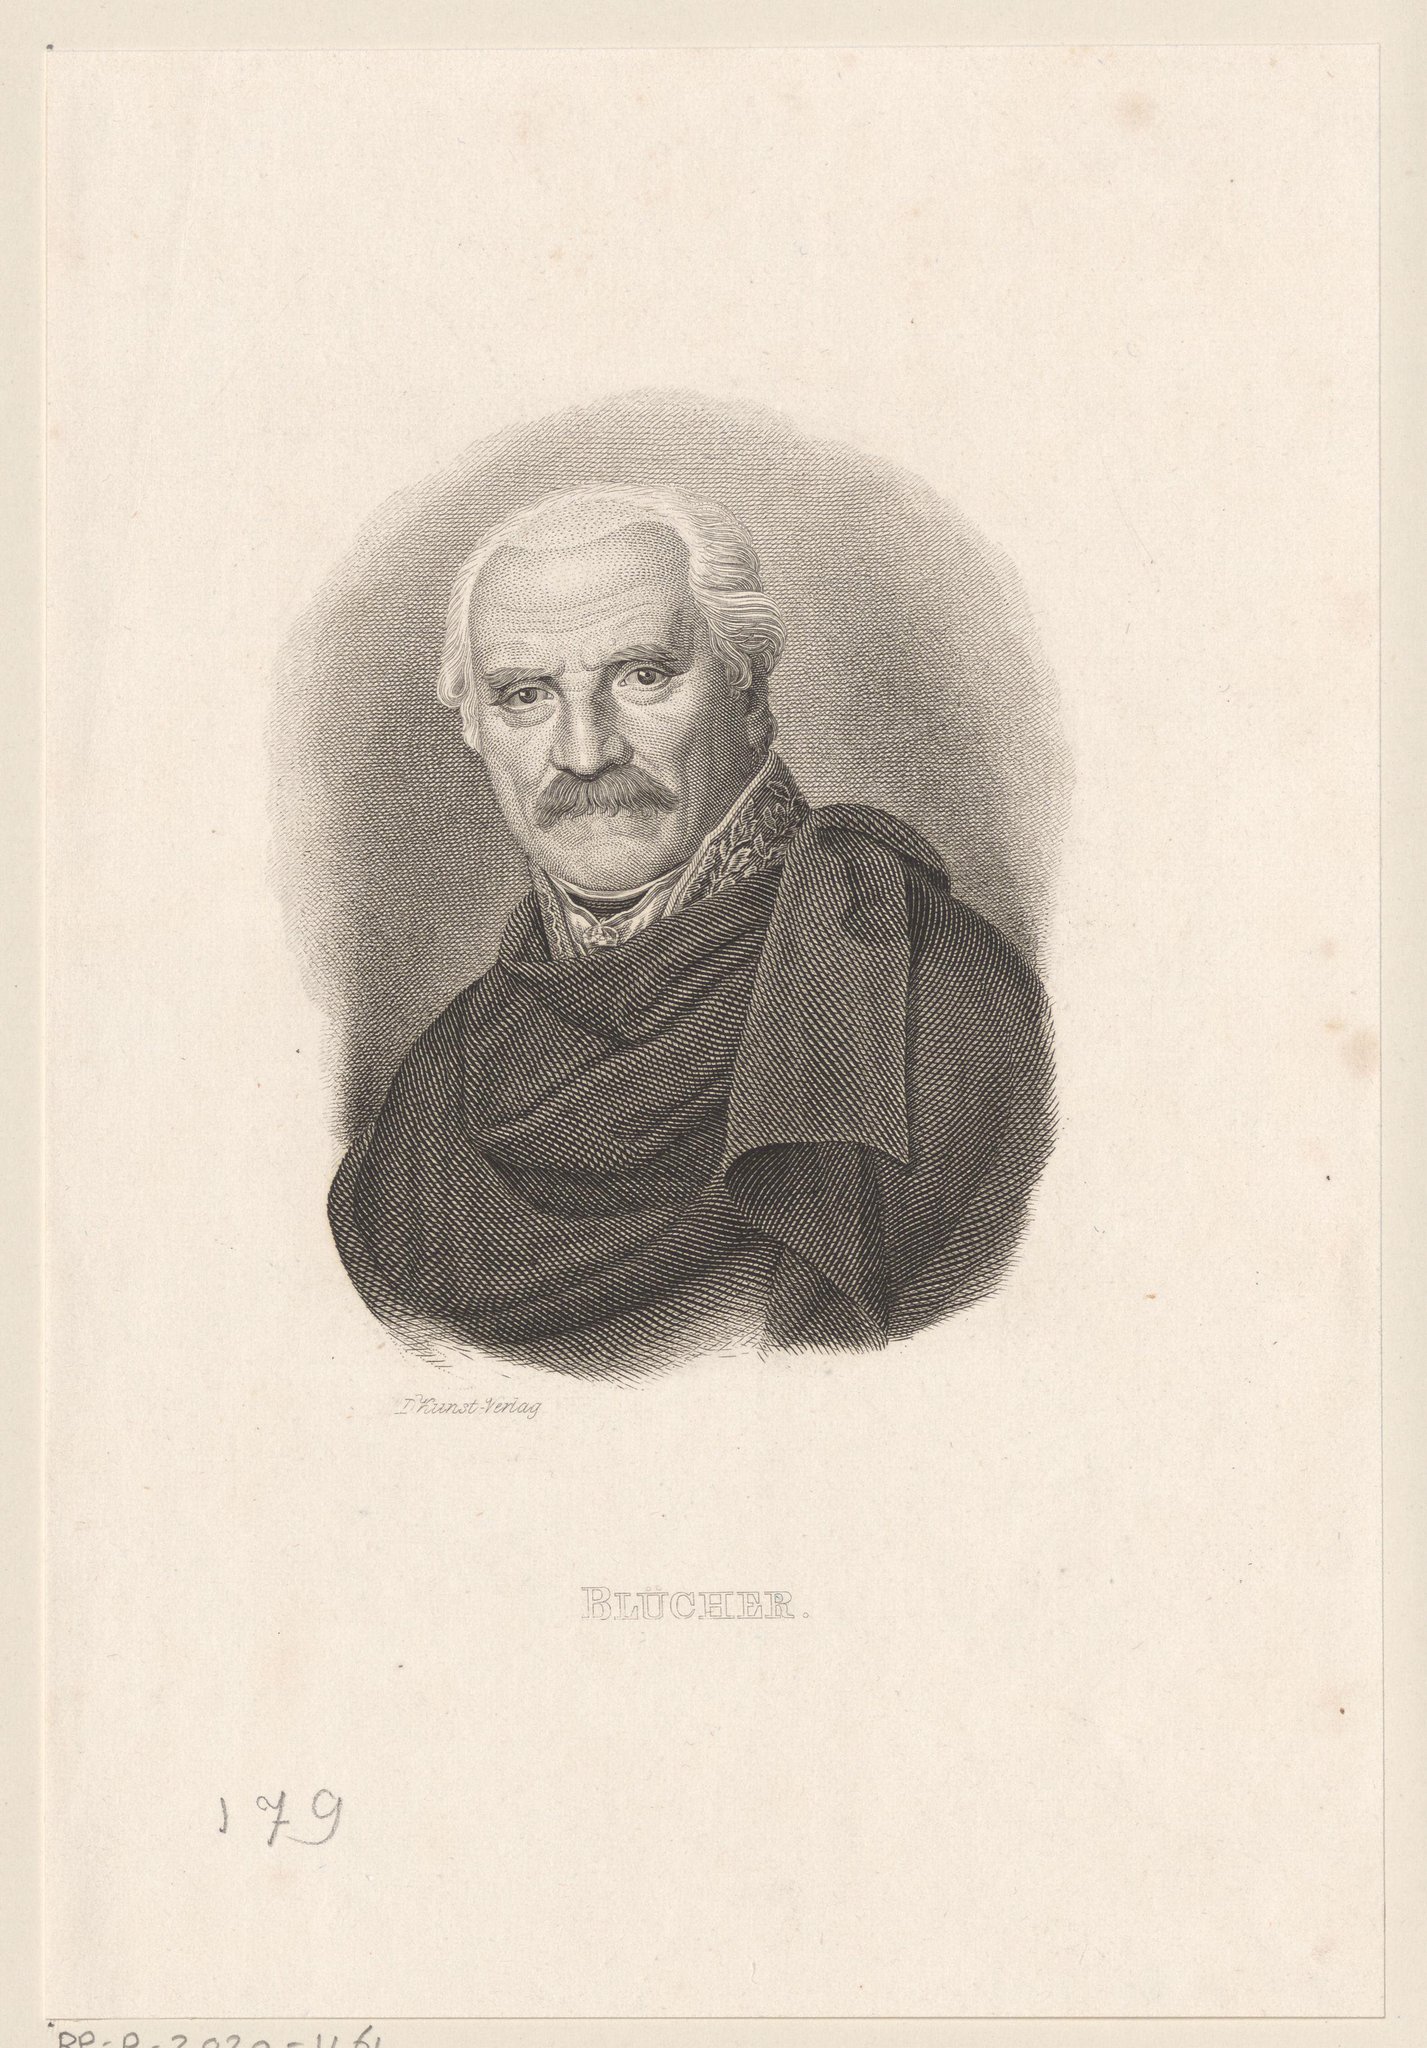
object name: print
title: Blücher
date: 1800-1849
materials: paper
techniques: engraving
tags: commander-in-chief, general, marshal, historical persons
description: Andere staat van de prent verschenen in: Sporschil, Johann. Die grosse Chronik. Geschichte des Krieges (...) gegen Napoleon Bonaparte in den Jahren 1813, 1814 und 1815. Braunschweig: George Westermann, 1841. Prent ook verschenen in andere publicaties.